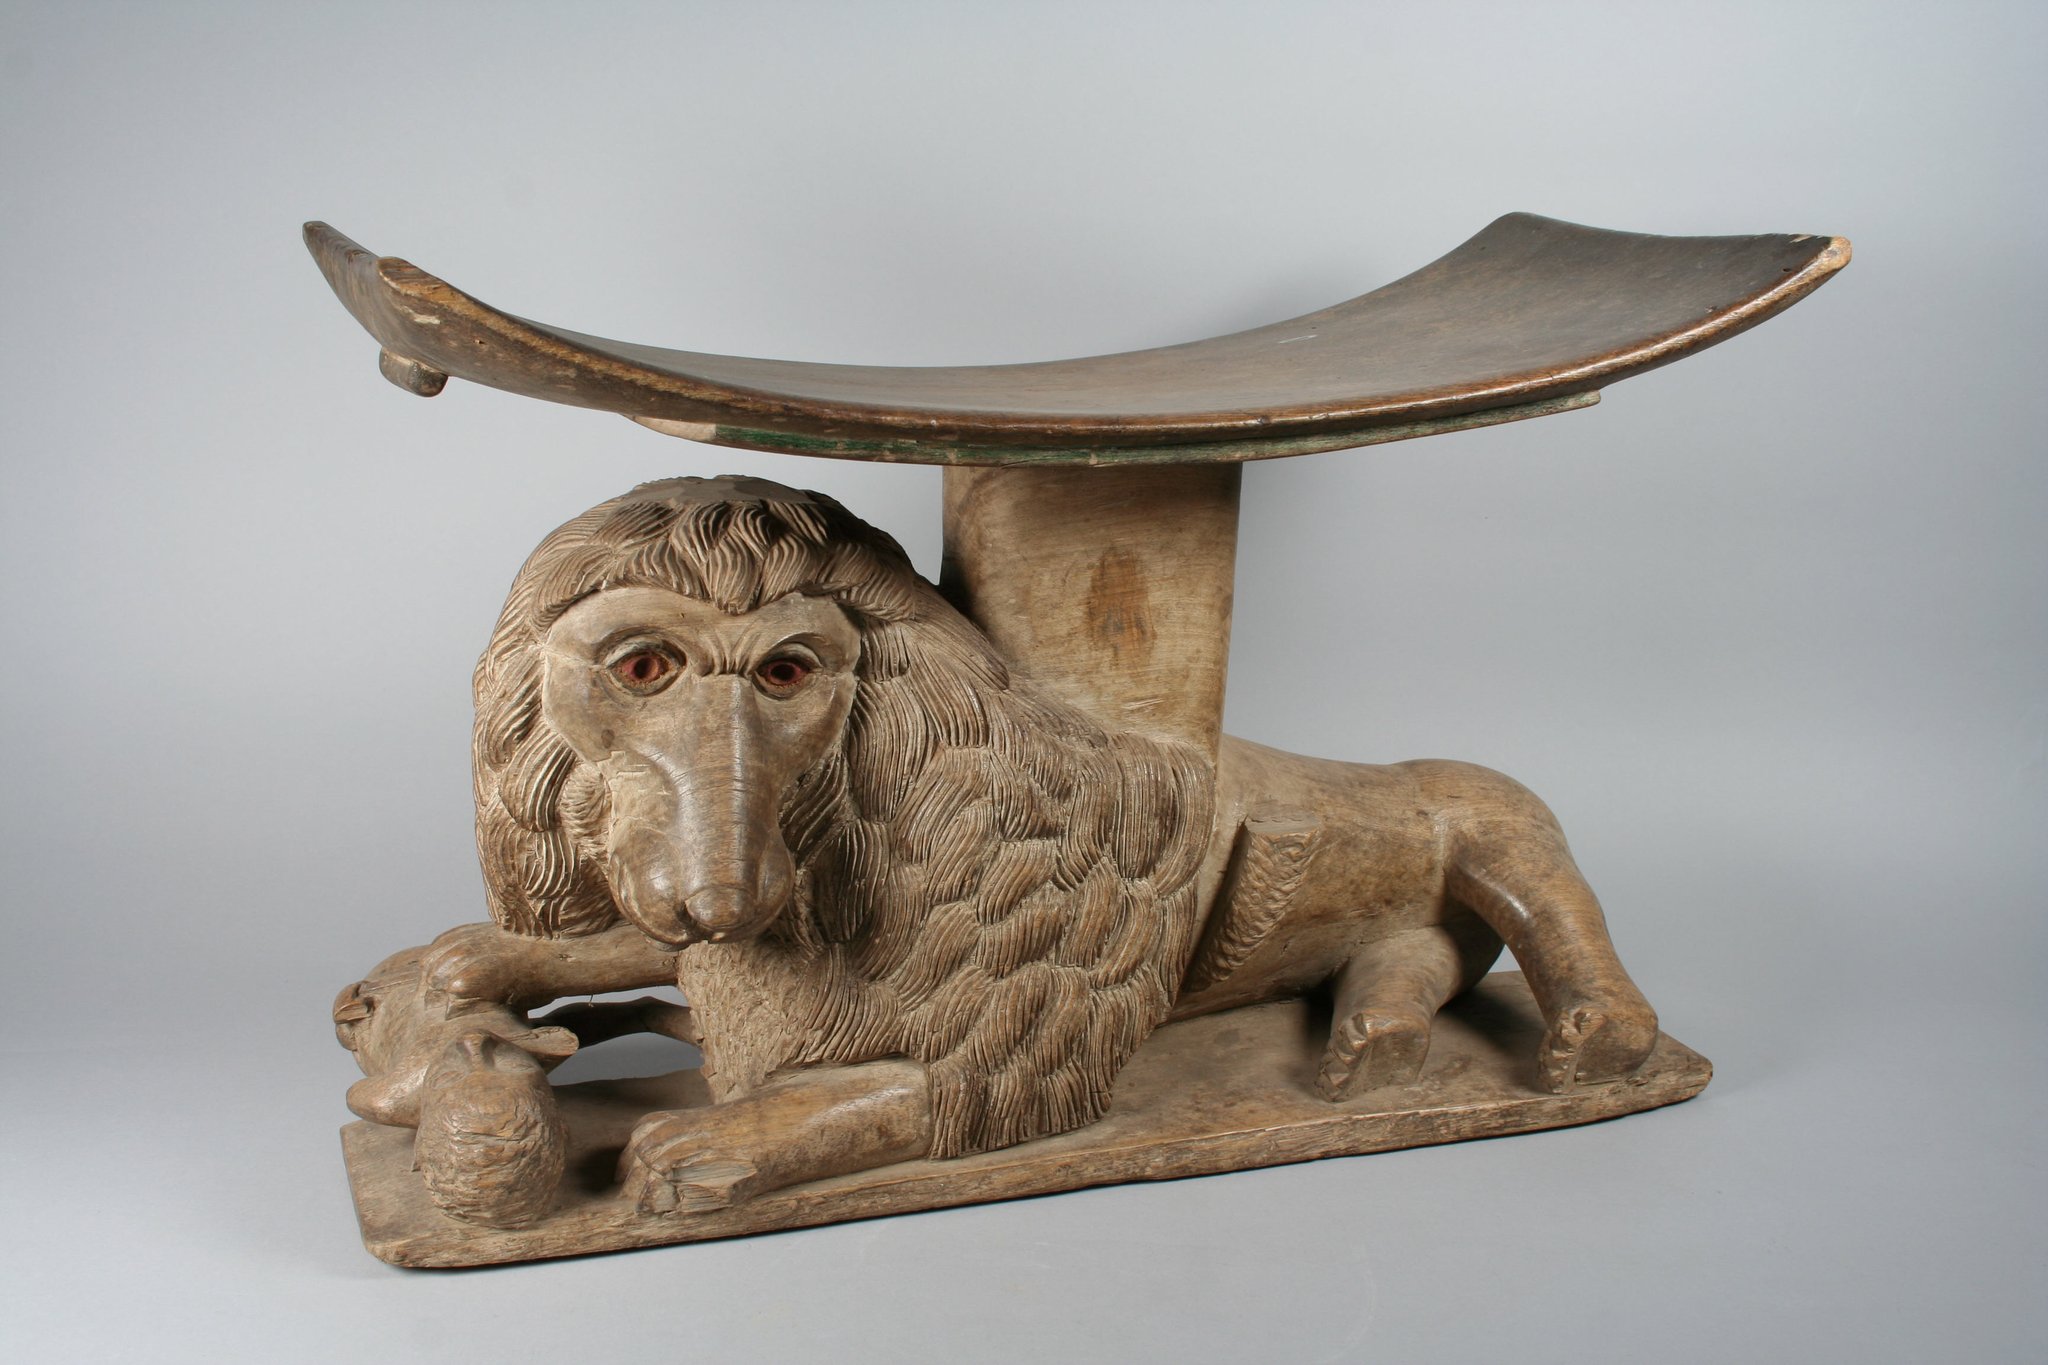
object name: stool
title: Prestige Stool: Lion Base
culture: akan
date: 1801-1900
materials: wood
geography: ghana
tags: lions